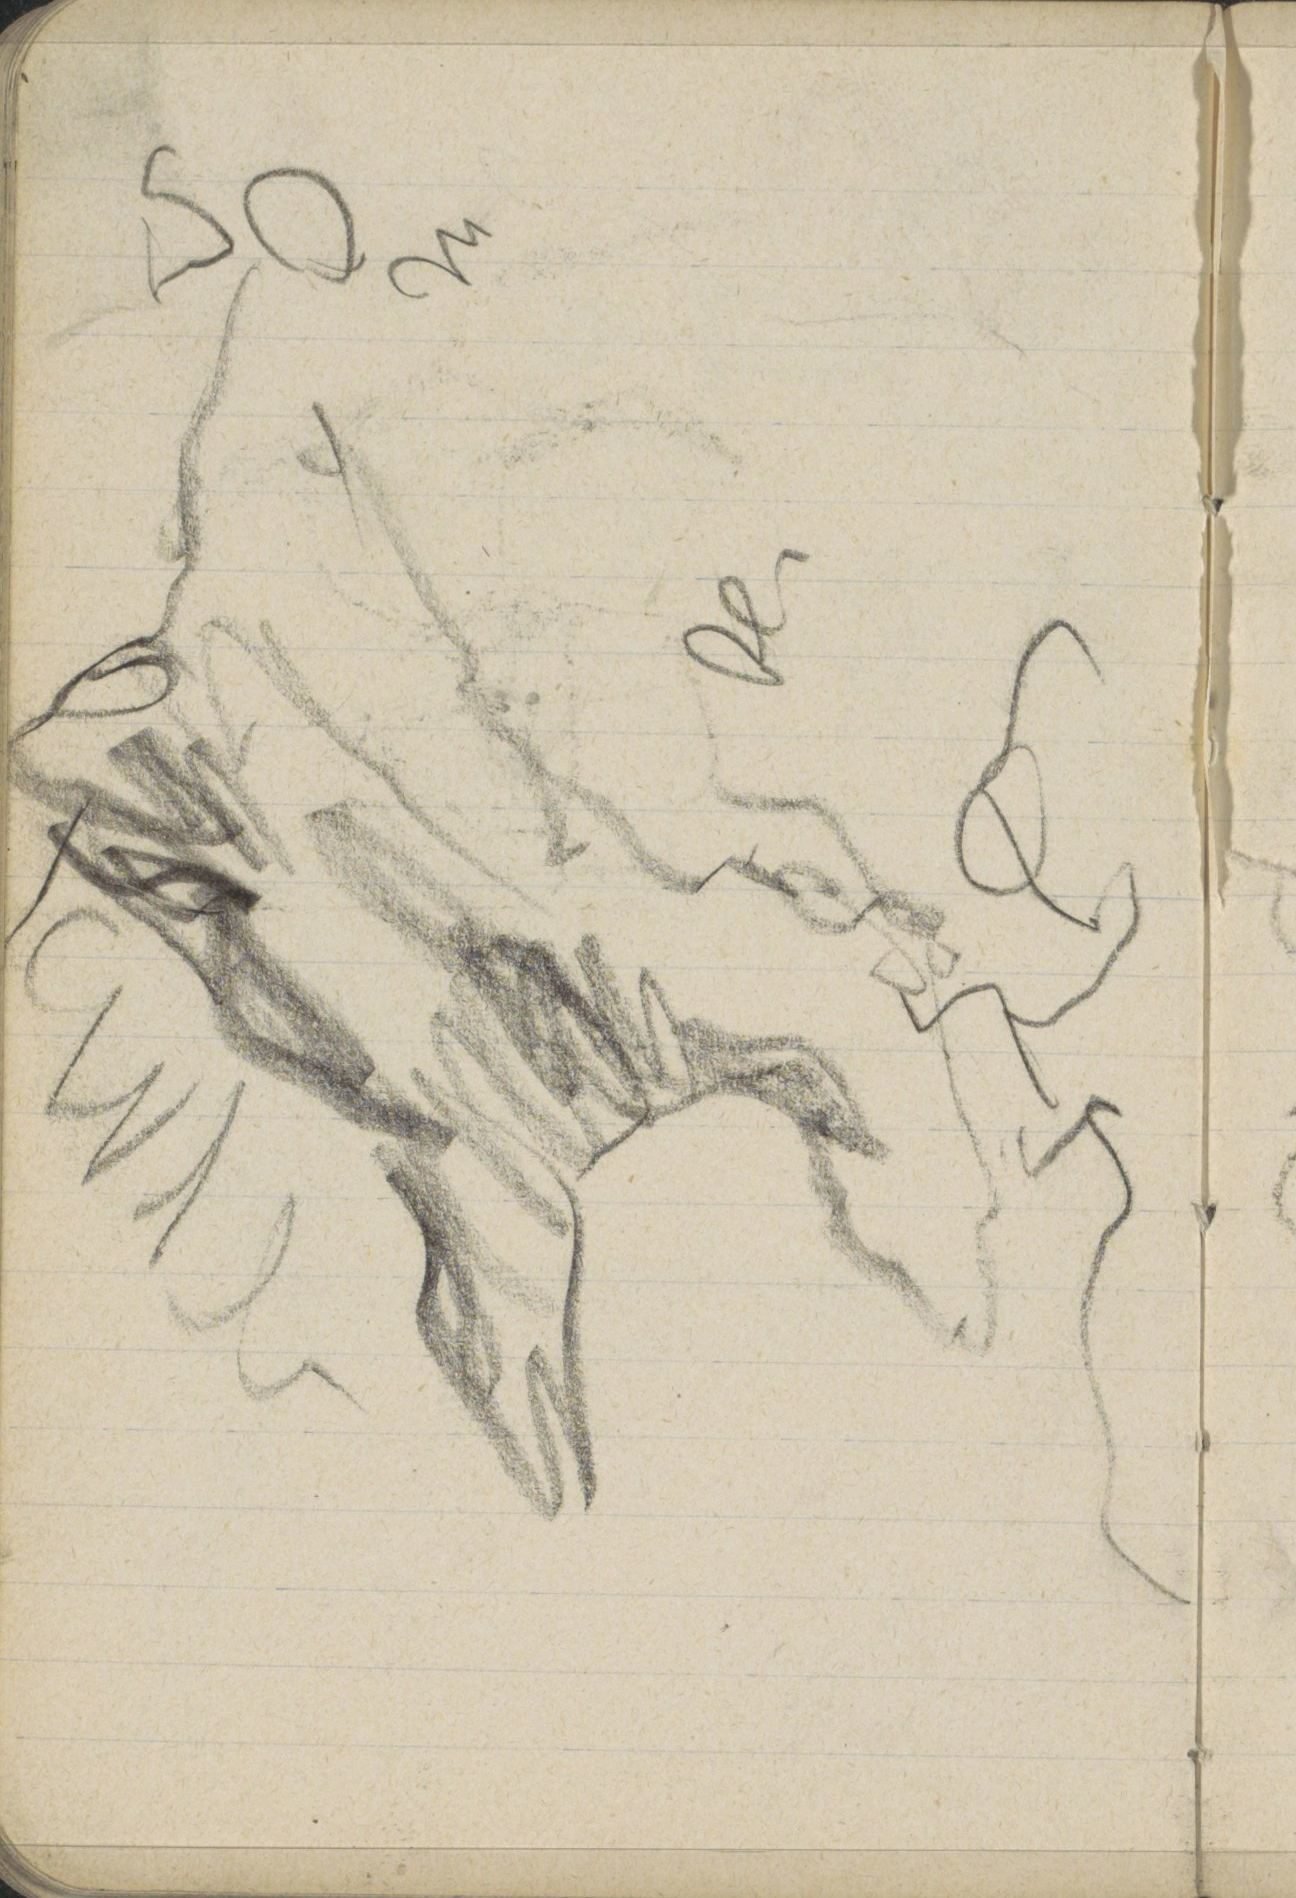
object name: sketchbook leaf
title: Studie, mogelijk van een wolkenlucht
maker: george hendrik breitner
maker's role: draughtsman, painter, print maker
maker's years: 1857-1923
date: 1903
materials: chalk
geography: amsterdam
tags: clouds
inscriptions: kleurnotitie, handgeschreven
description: Pagina 75 uit een schetsboek met 32 bladen.